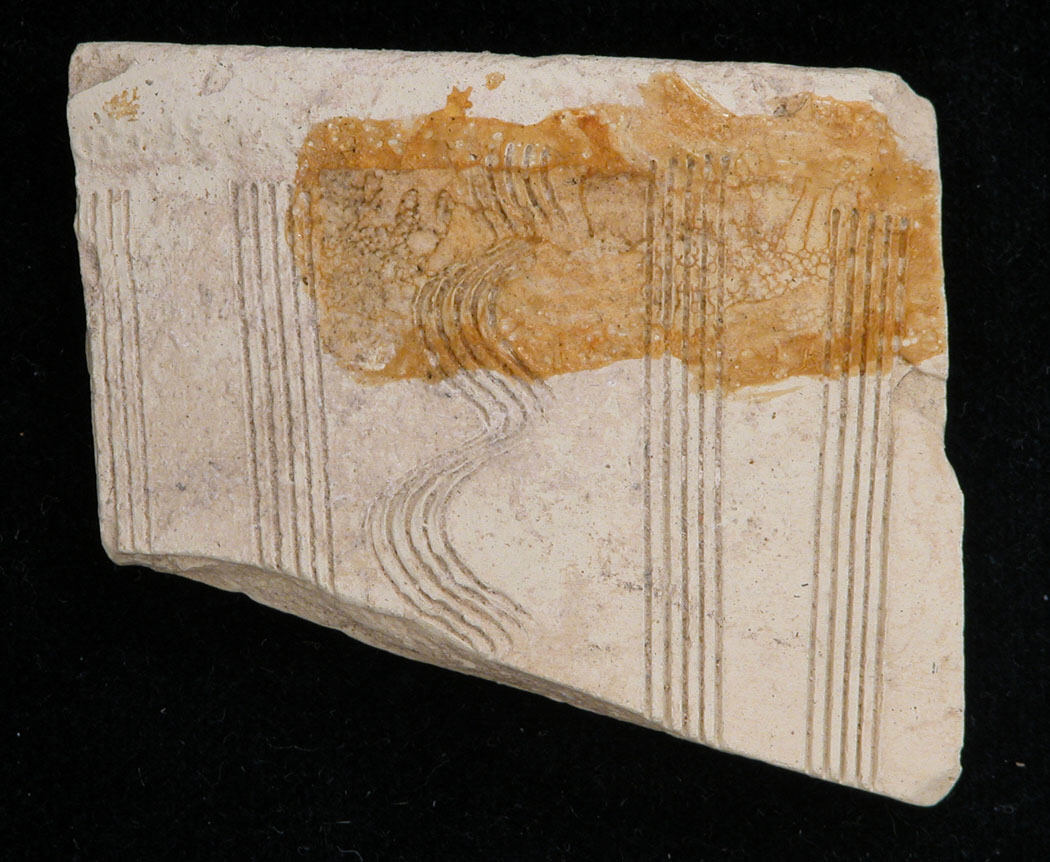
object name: fragment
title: Ceramic Fragment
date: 801-1000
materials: earthenware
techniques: incising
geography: saudi arabia